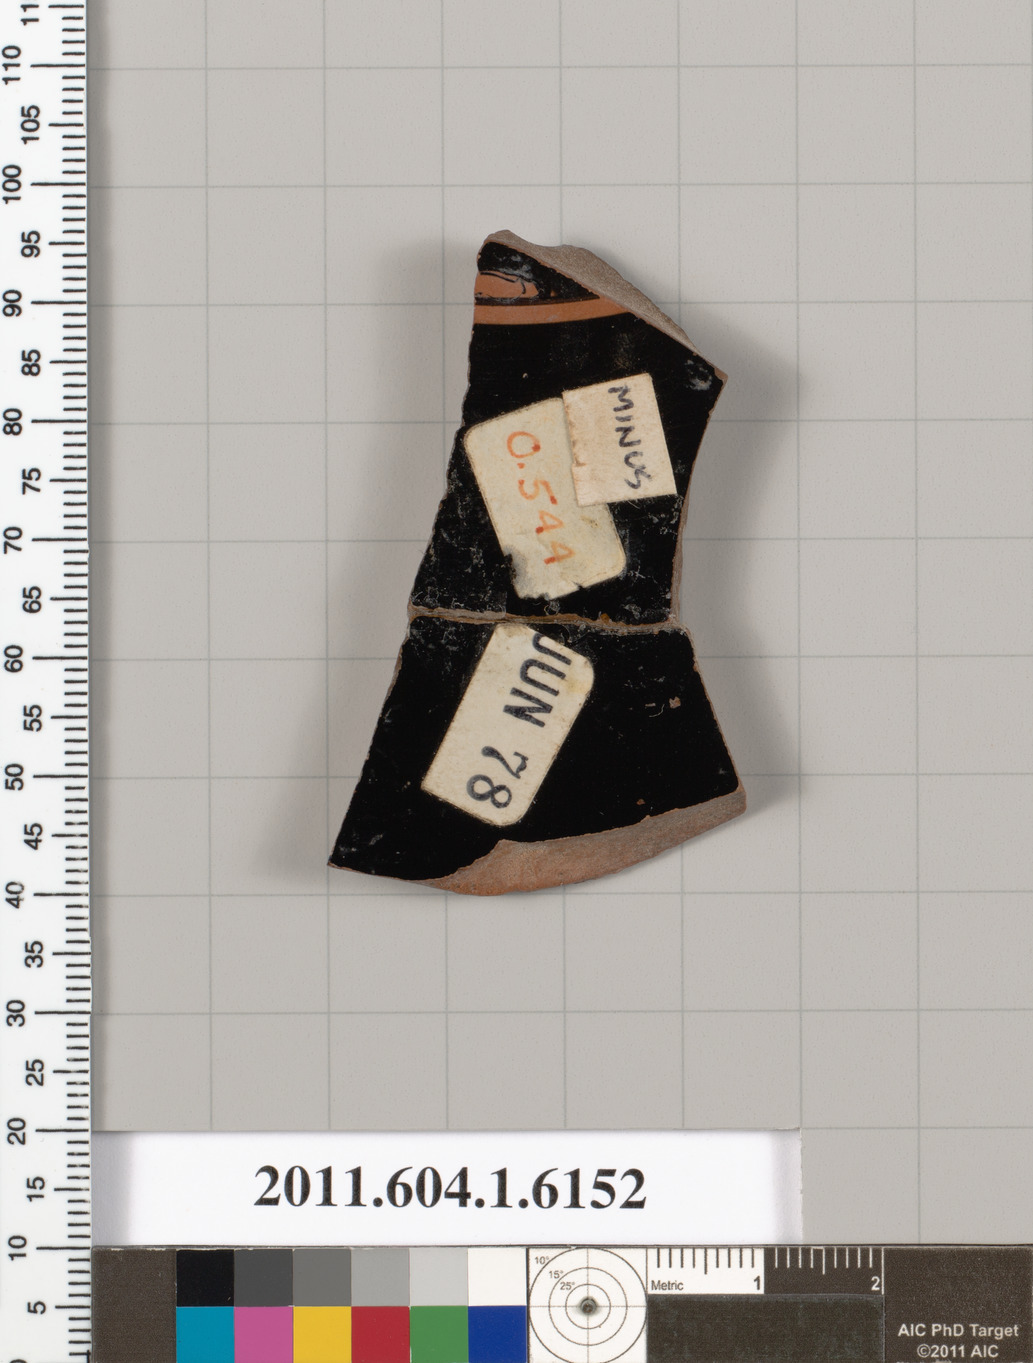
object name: kylix fragment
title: Terracotta fragment of a kylix (drinking cup)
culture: greek, attic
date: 520-500 BCE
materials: terracotta